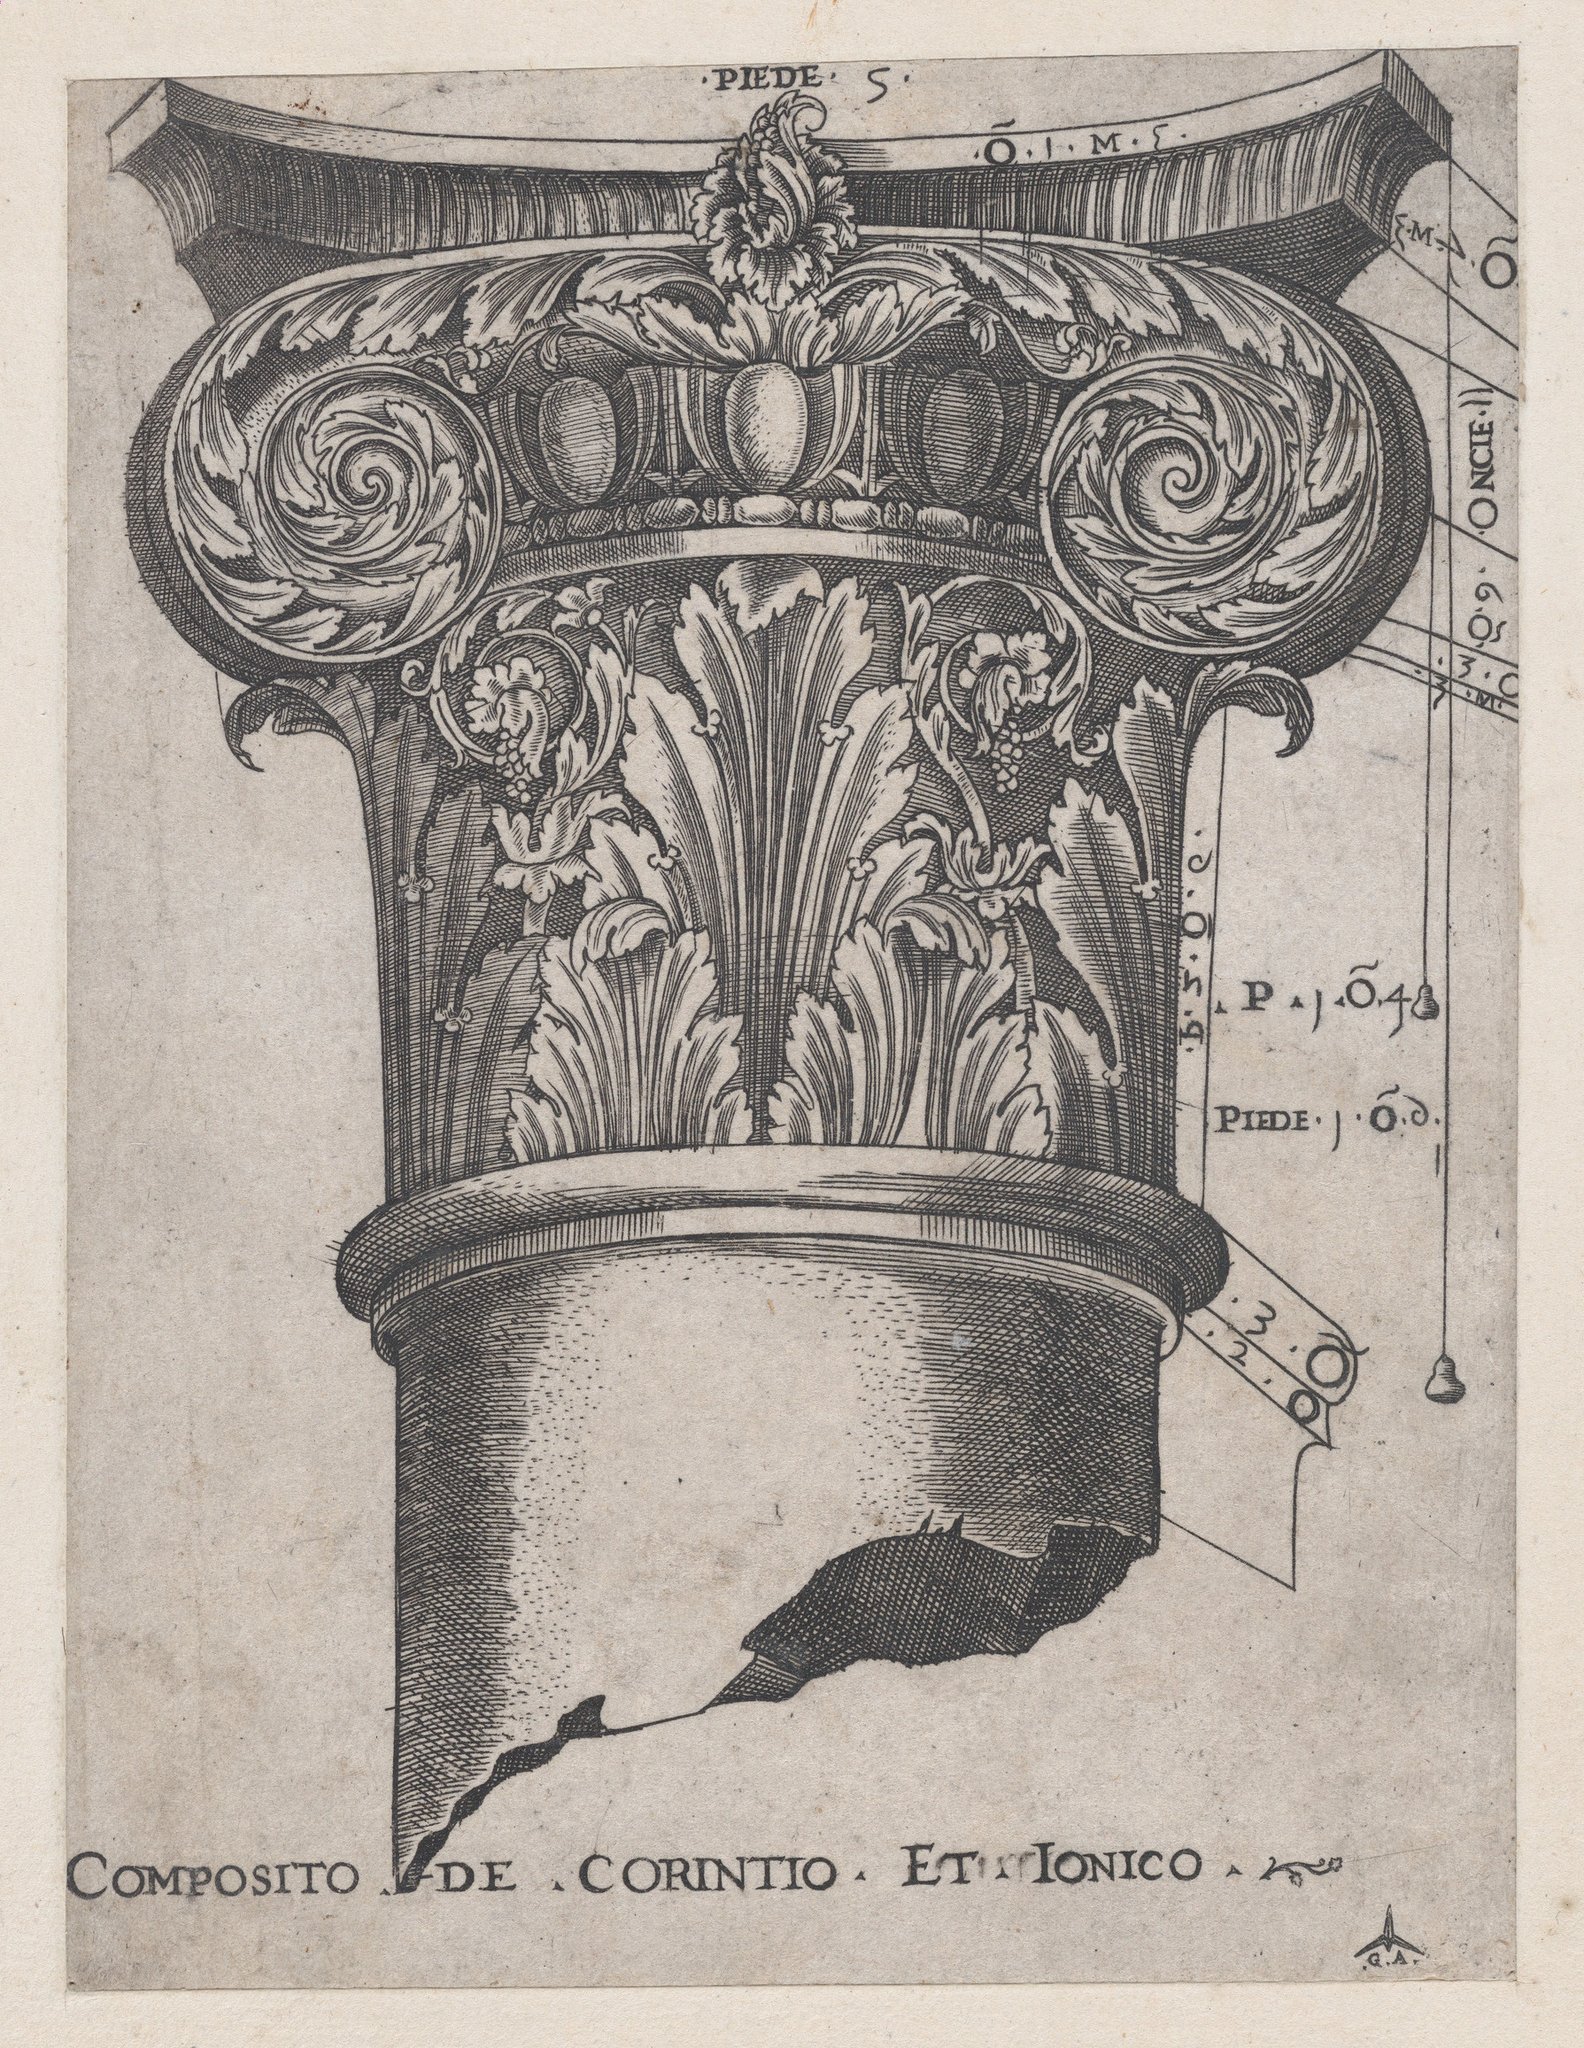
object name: print ornament architecture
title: Composite of Corinthian and Ionic, from "Speculum Romanae Magnificentiae"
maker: monogrammist g.a. with the caltrop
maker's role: artist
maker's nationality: italian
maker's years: 1535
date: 1537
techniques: engraving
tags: capitals